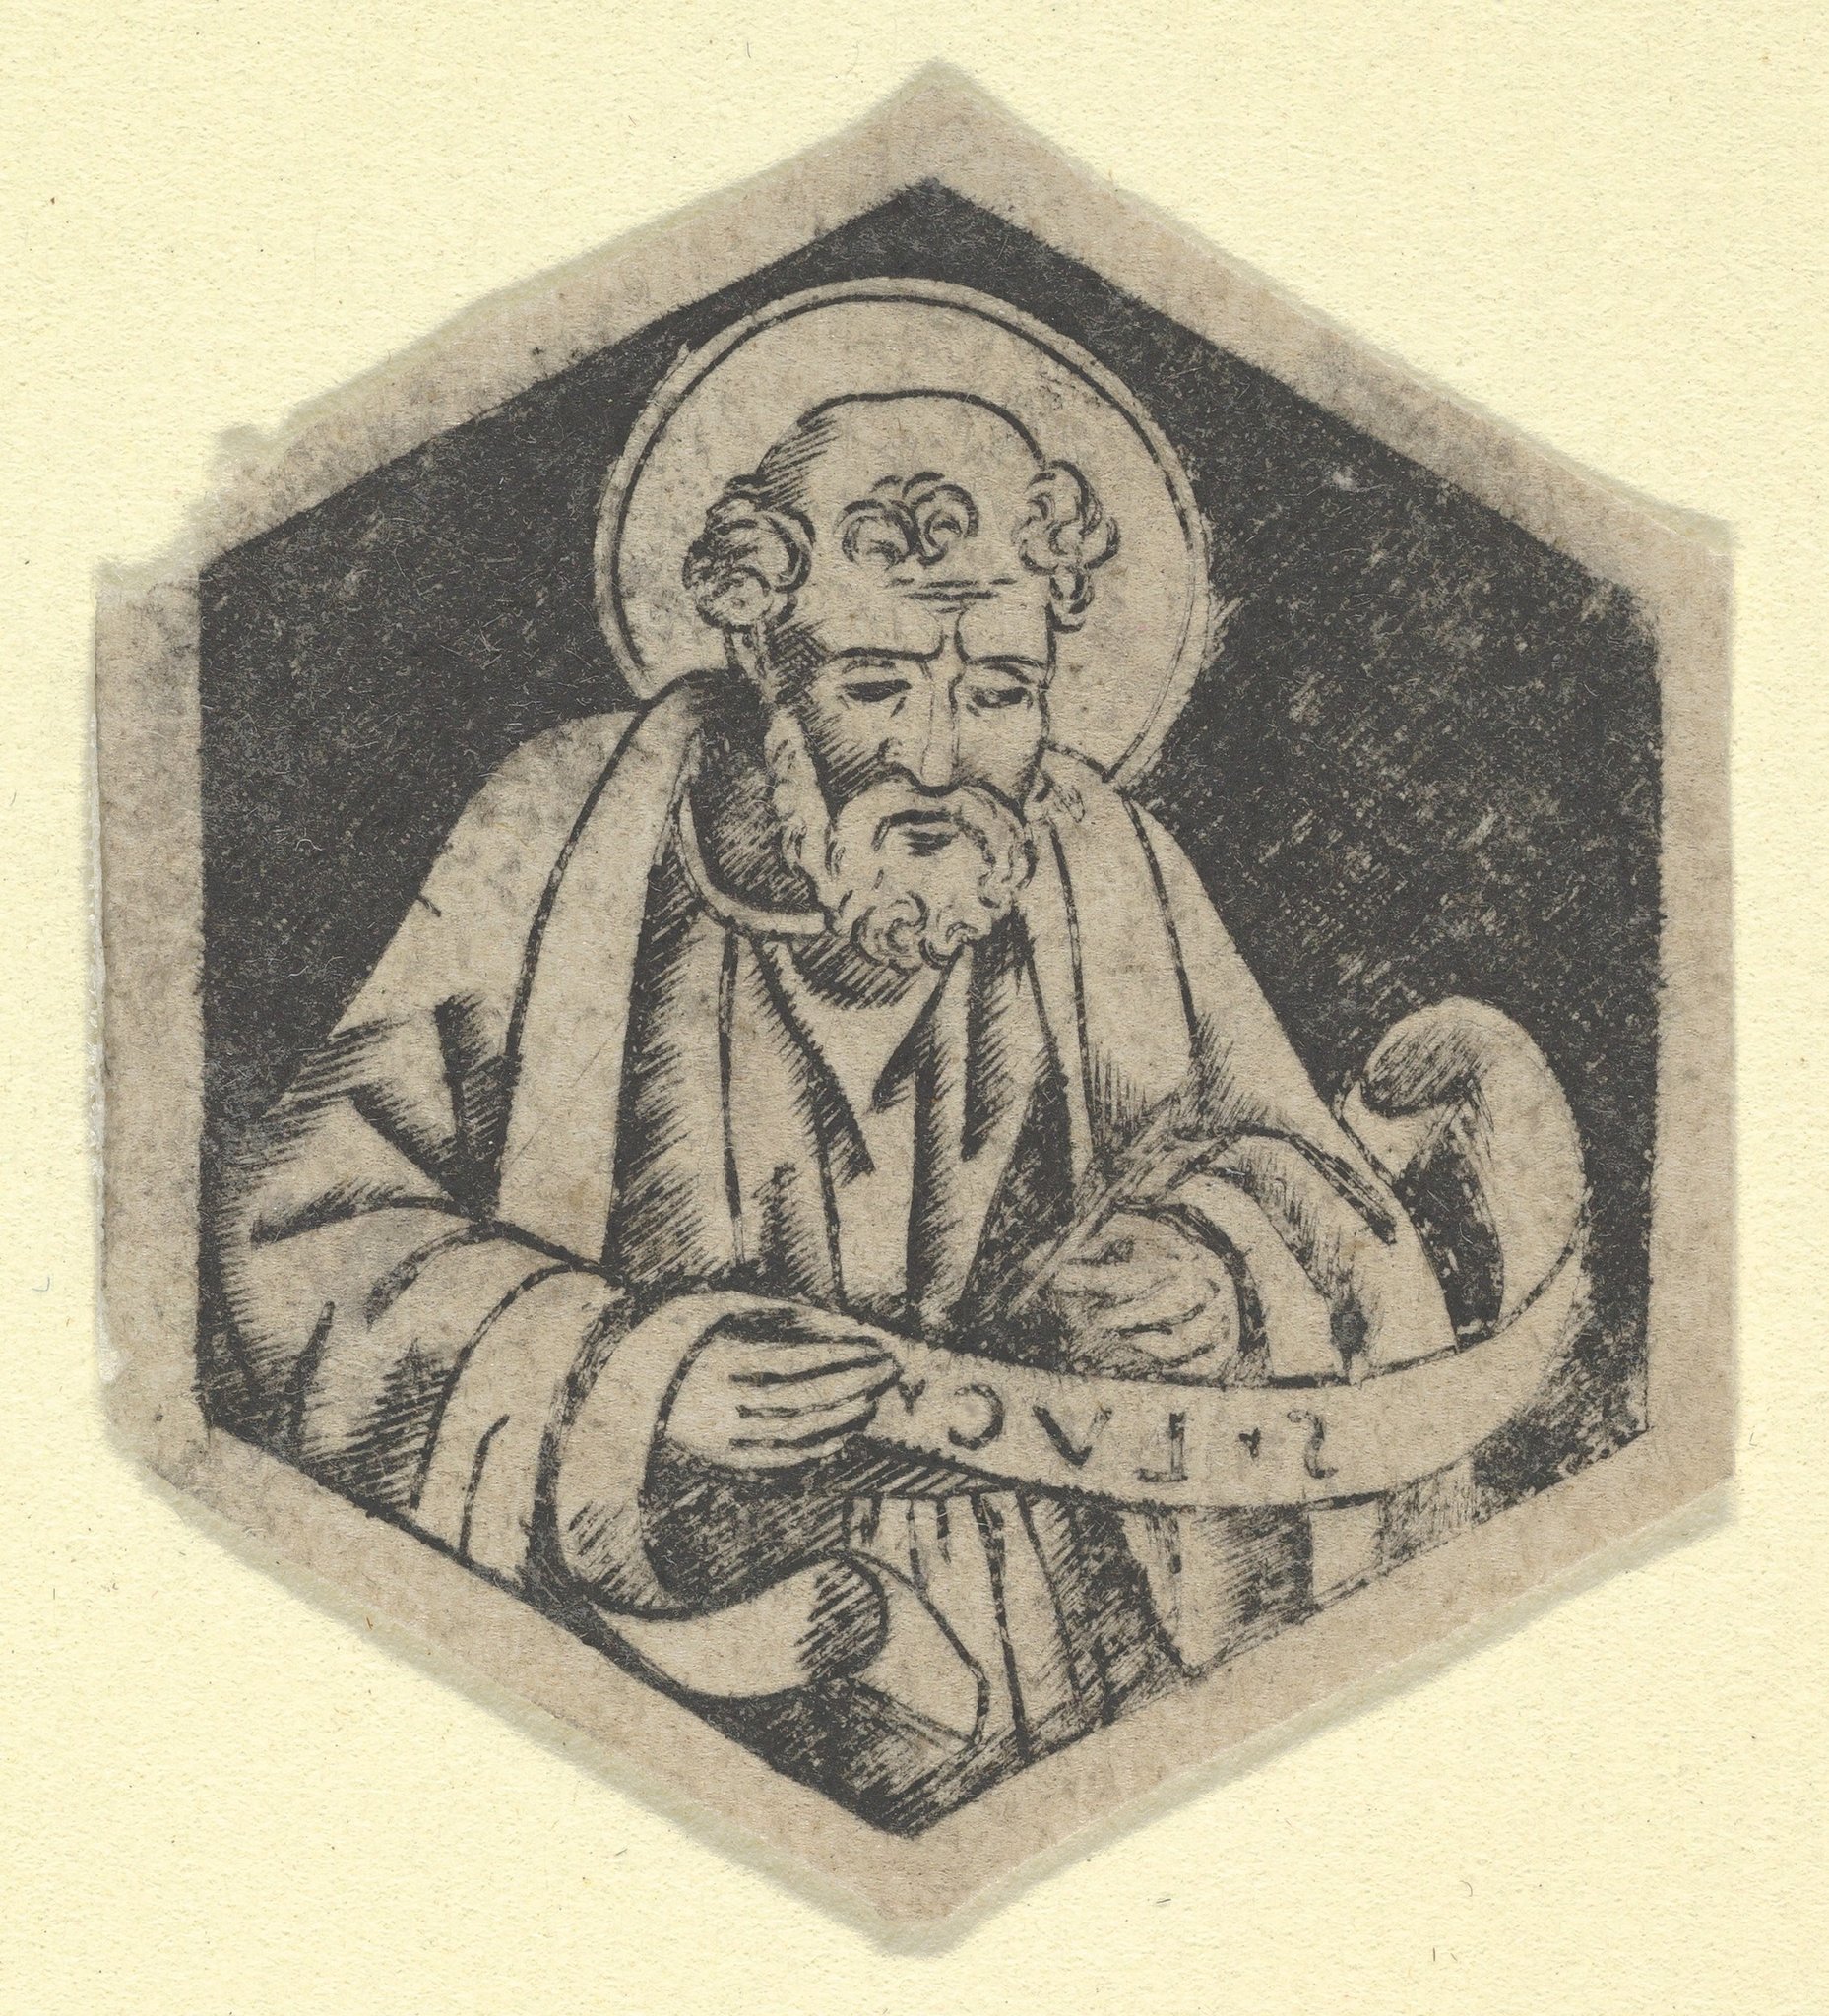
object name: print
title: St Luke the Evangelist, holding a banderole (possibly a modern impression)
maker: Anonymous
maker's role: artist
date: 1480-1520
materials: niello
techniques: engraving, printing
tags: portraits,saints